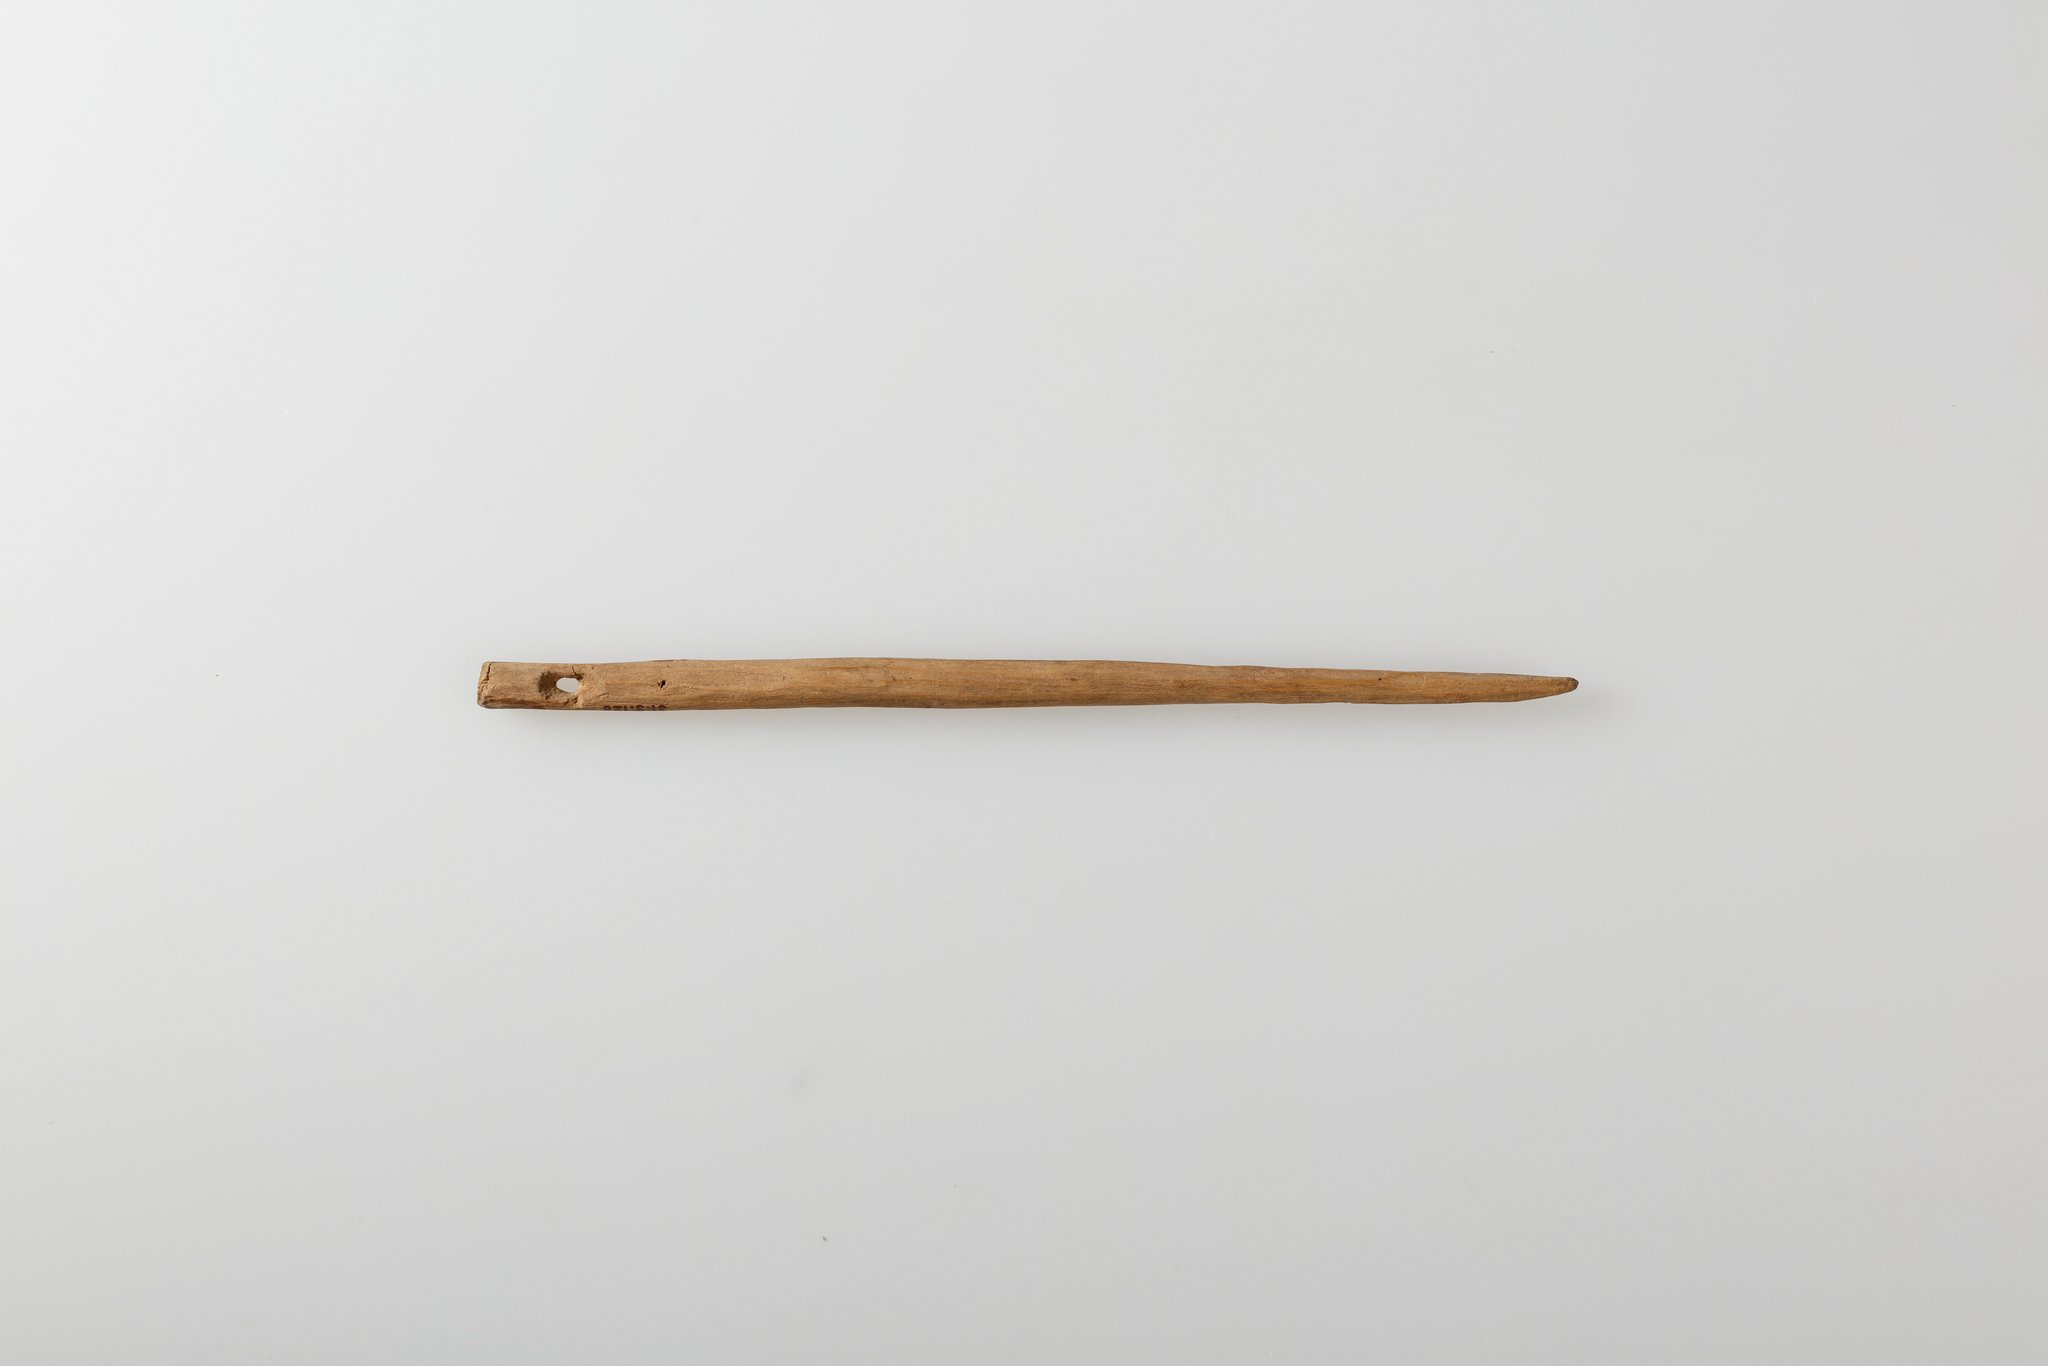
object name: embalmer's needle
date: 664-332 BCE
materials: wood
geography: egypt